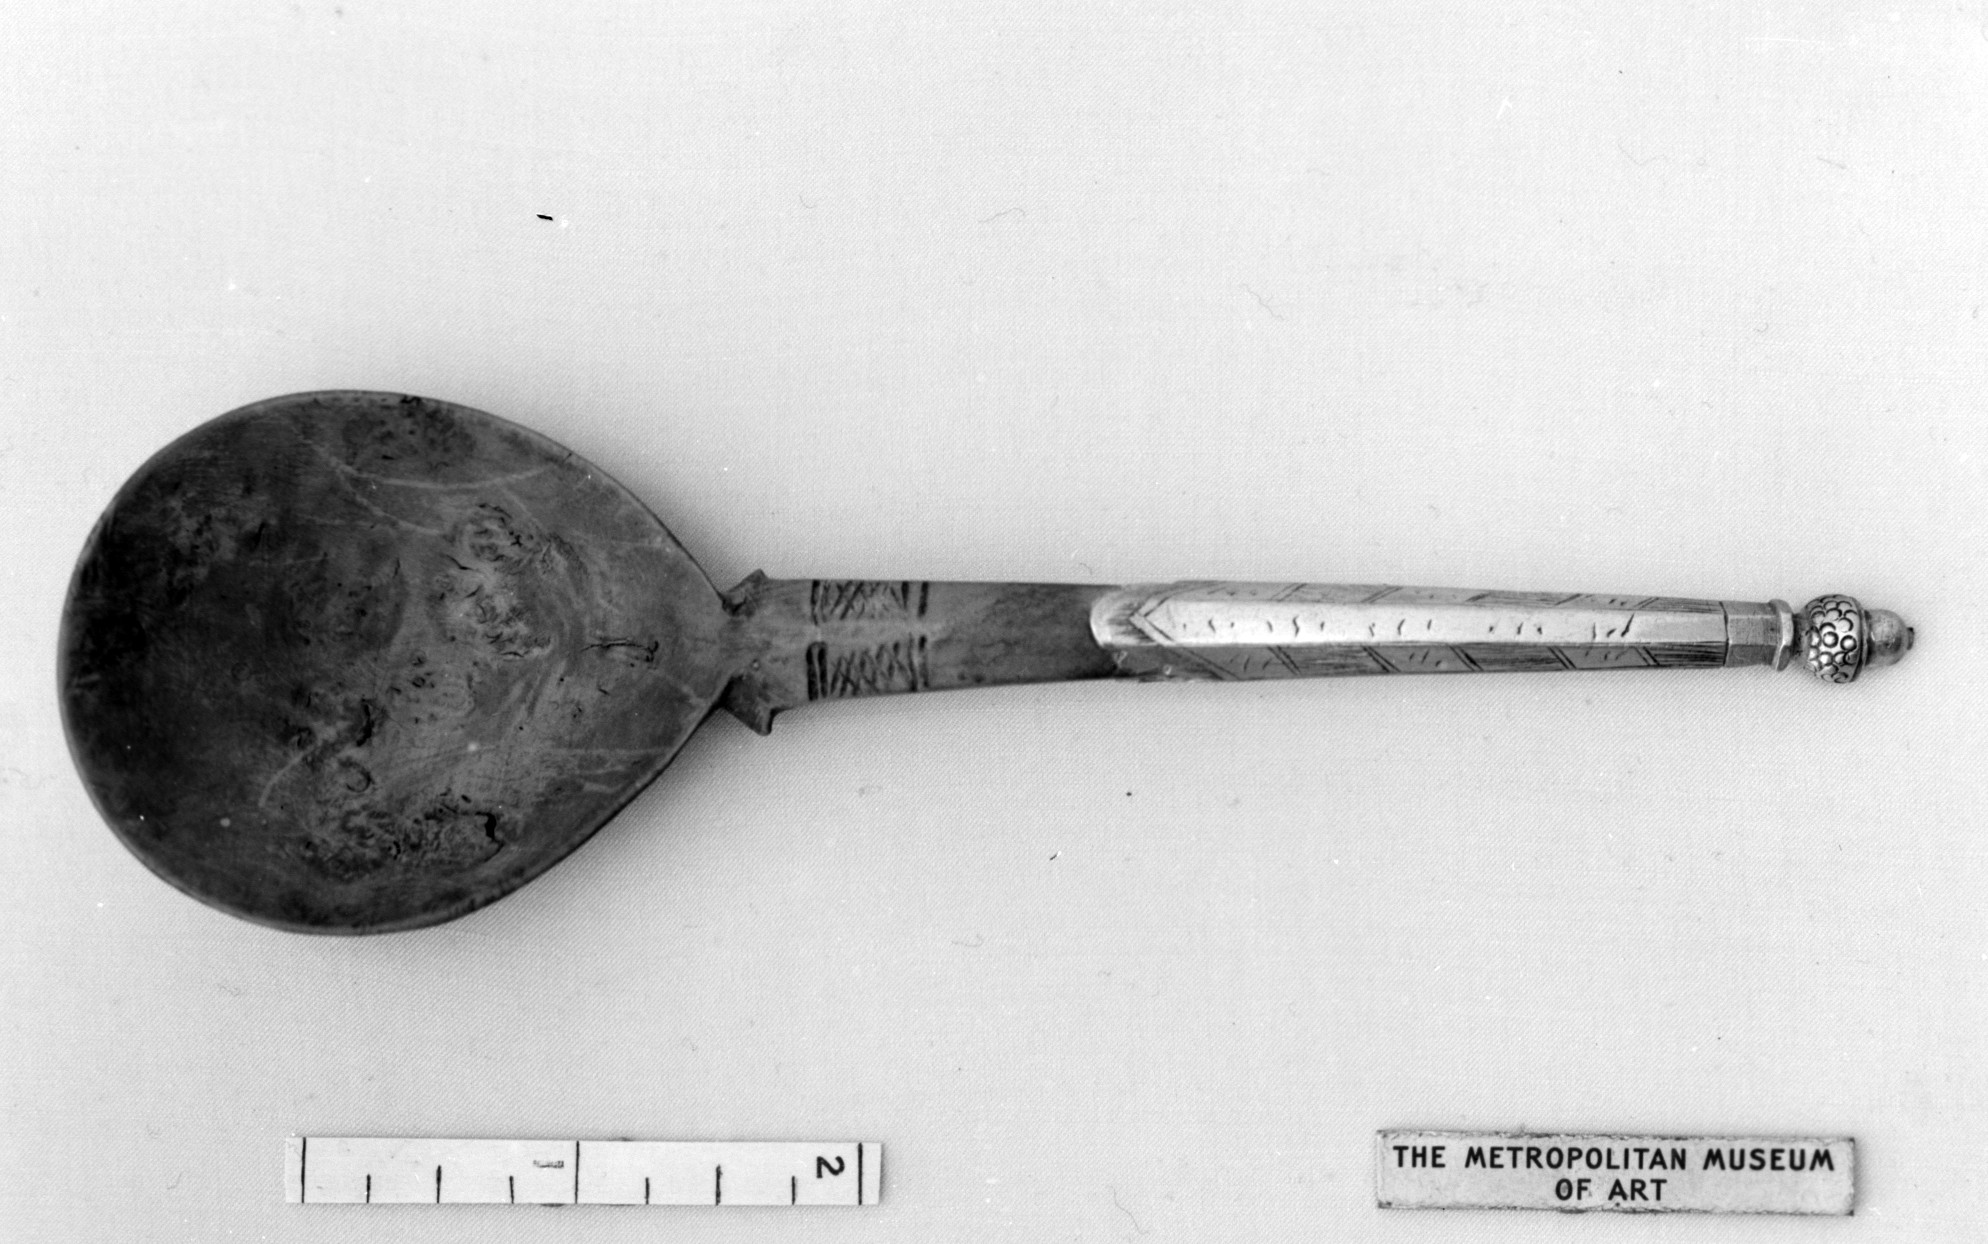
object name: spoon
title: Acorn-top spoon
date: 1551-1600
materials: silver, wood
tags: acorns